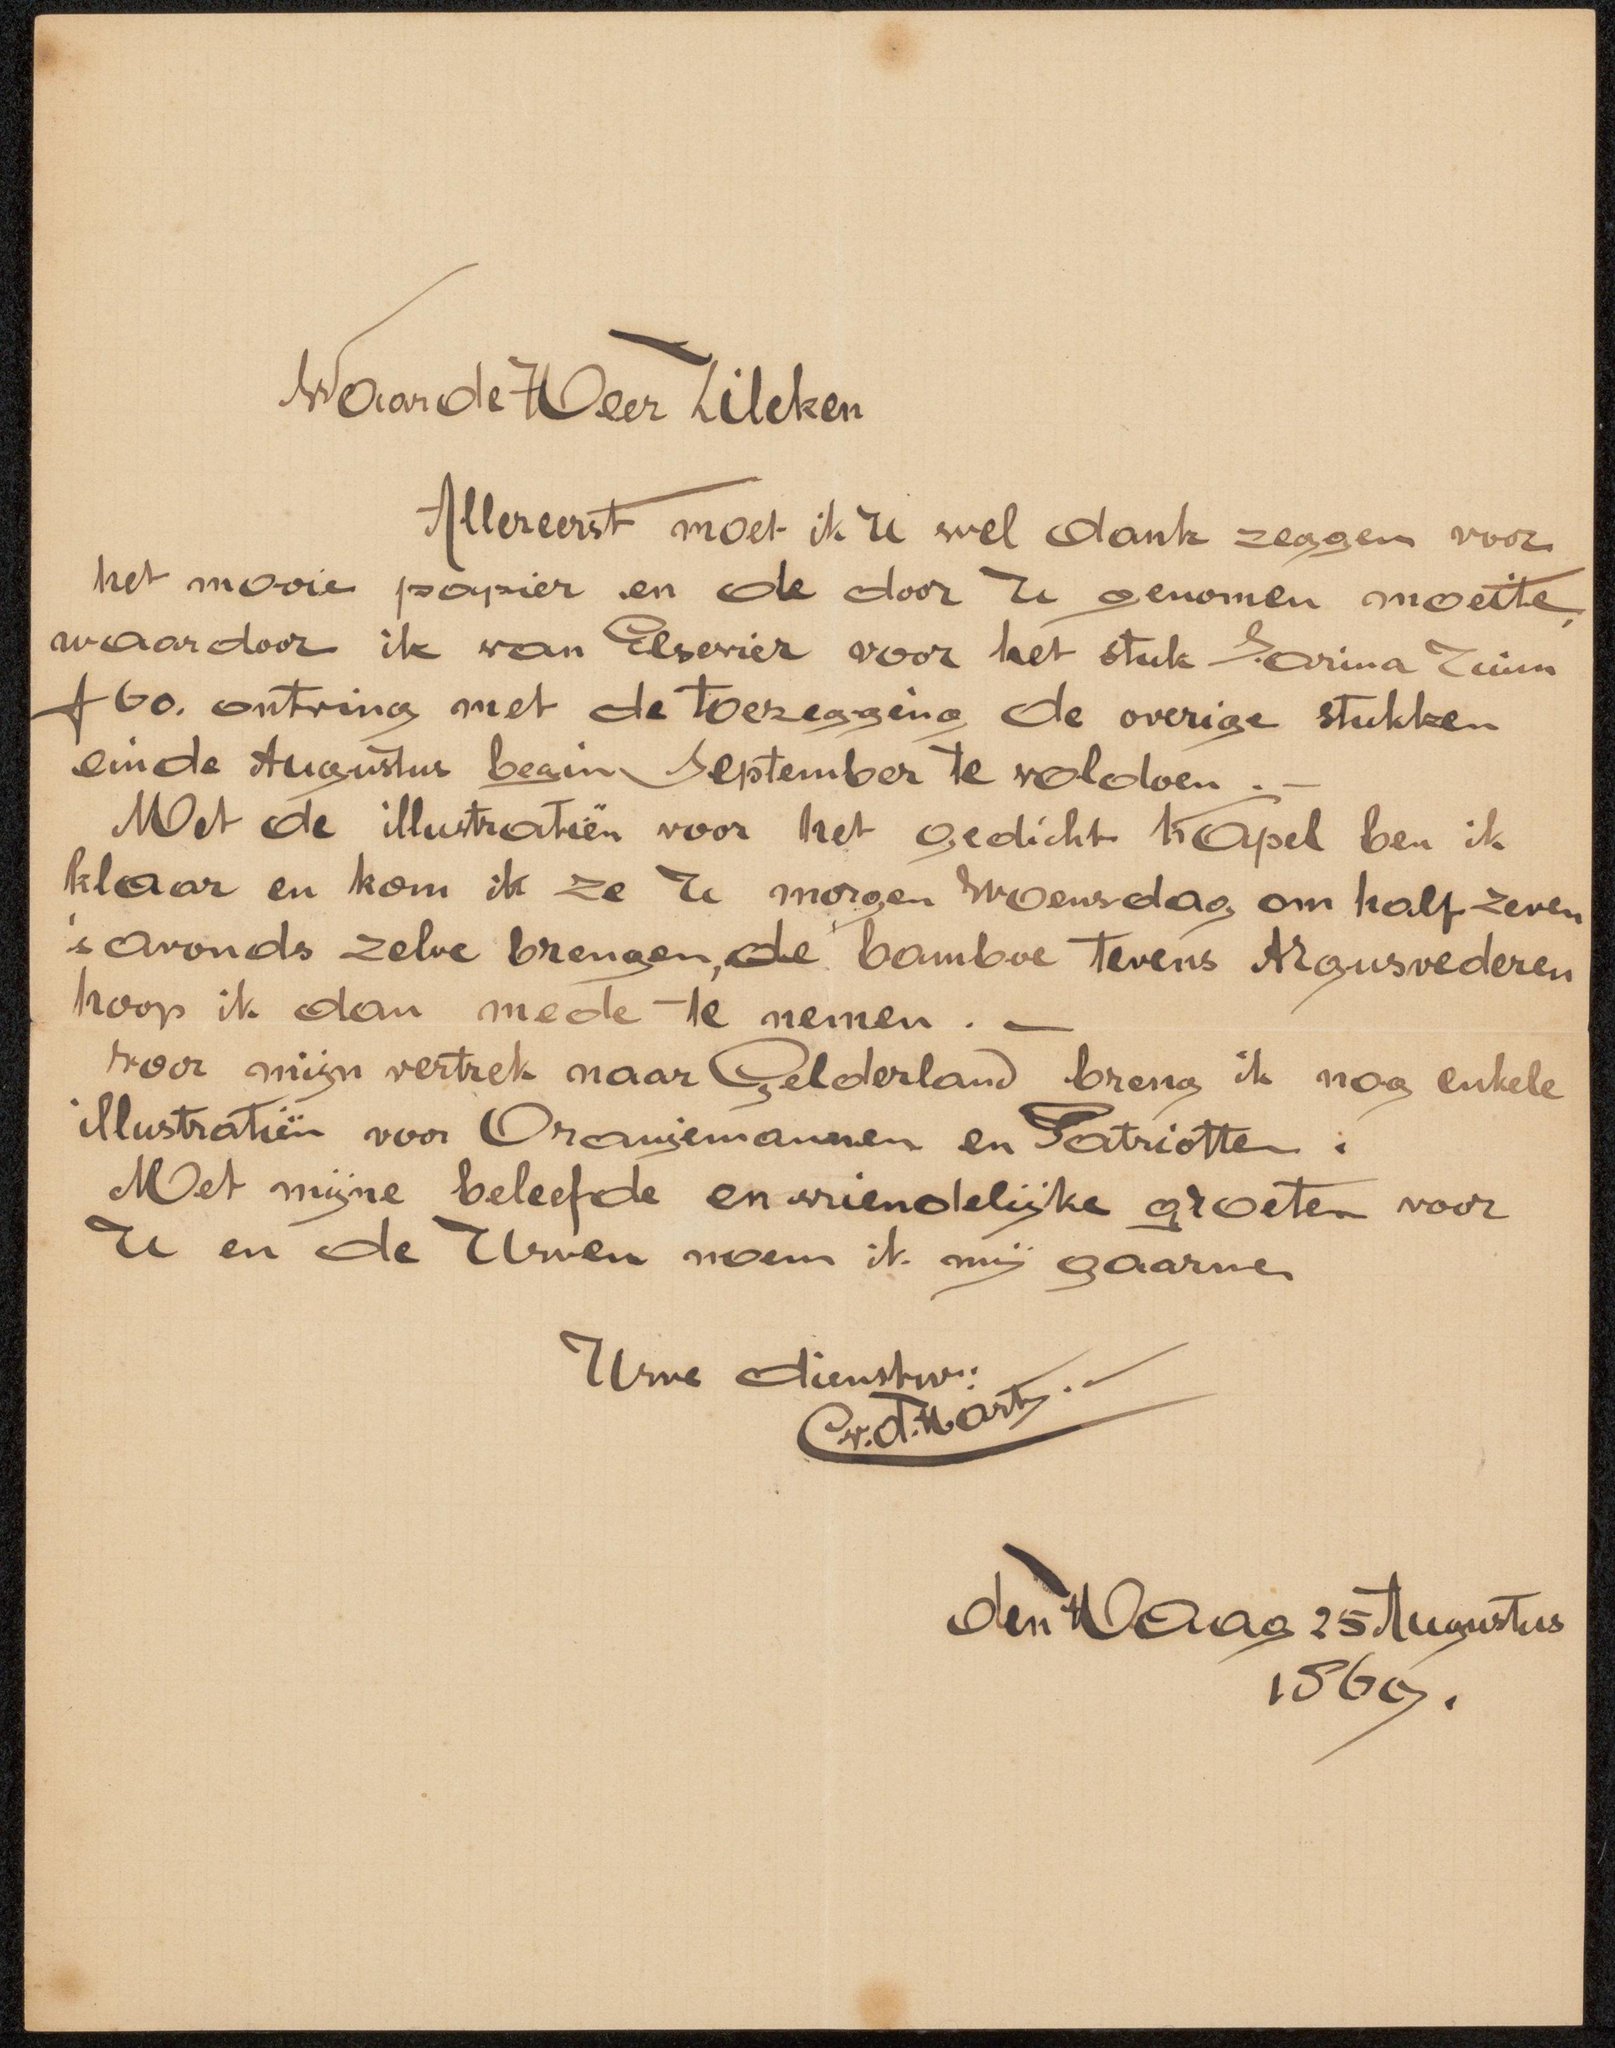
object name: letter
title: Brief aan Philip Zilcken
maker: cornelia van der hart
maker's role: print maker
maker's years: 1851-1940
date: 1869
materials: ink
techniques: pen, writing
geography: the hague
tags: the hague, painter, draughtsman, philip zilcken, literature ~ arts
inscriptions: collector's mark: ‘RPK’